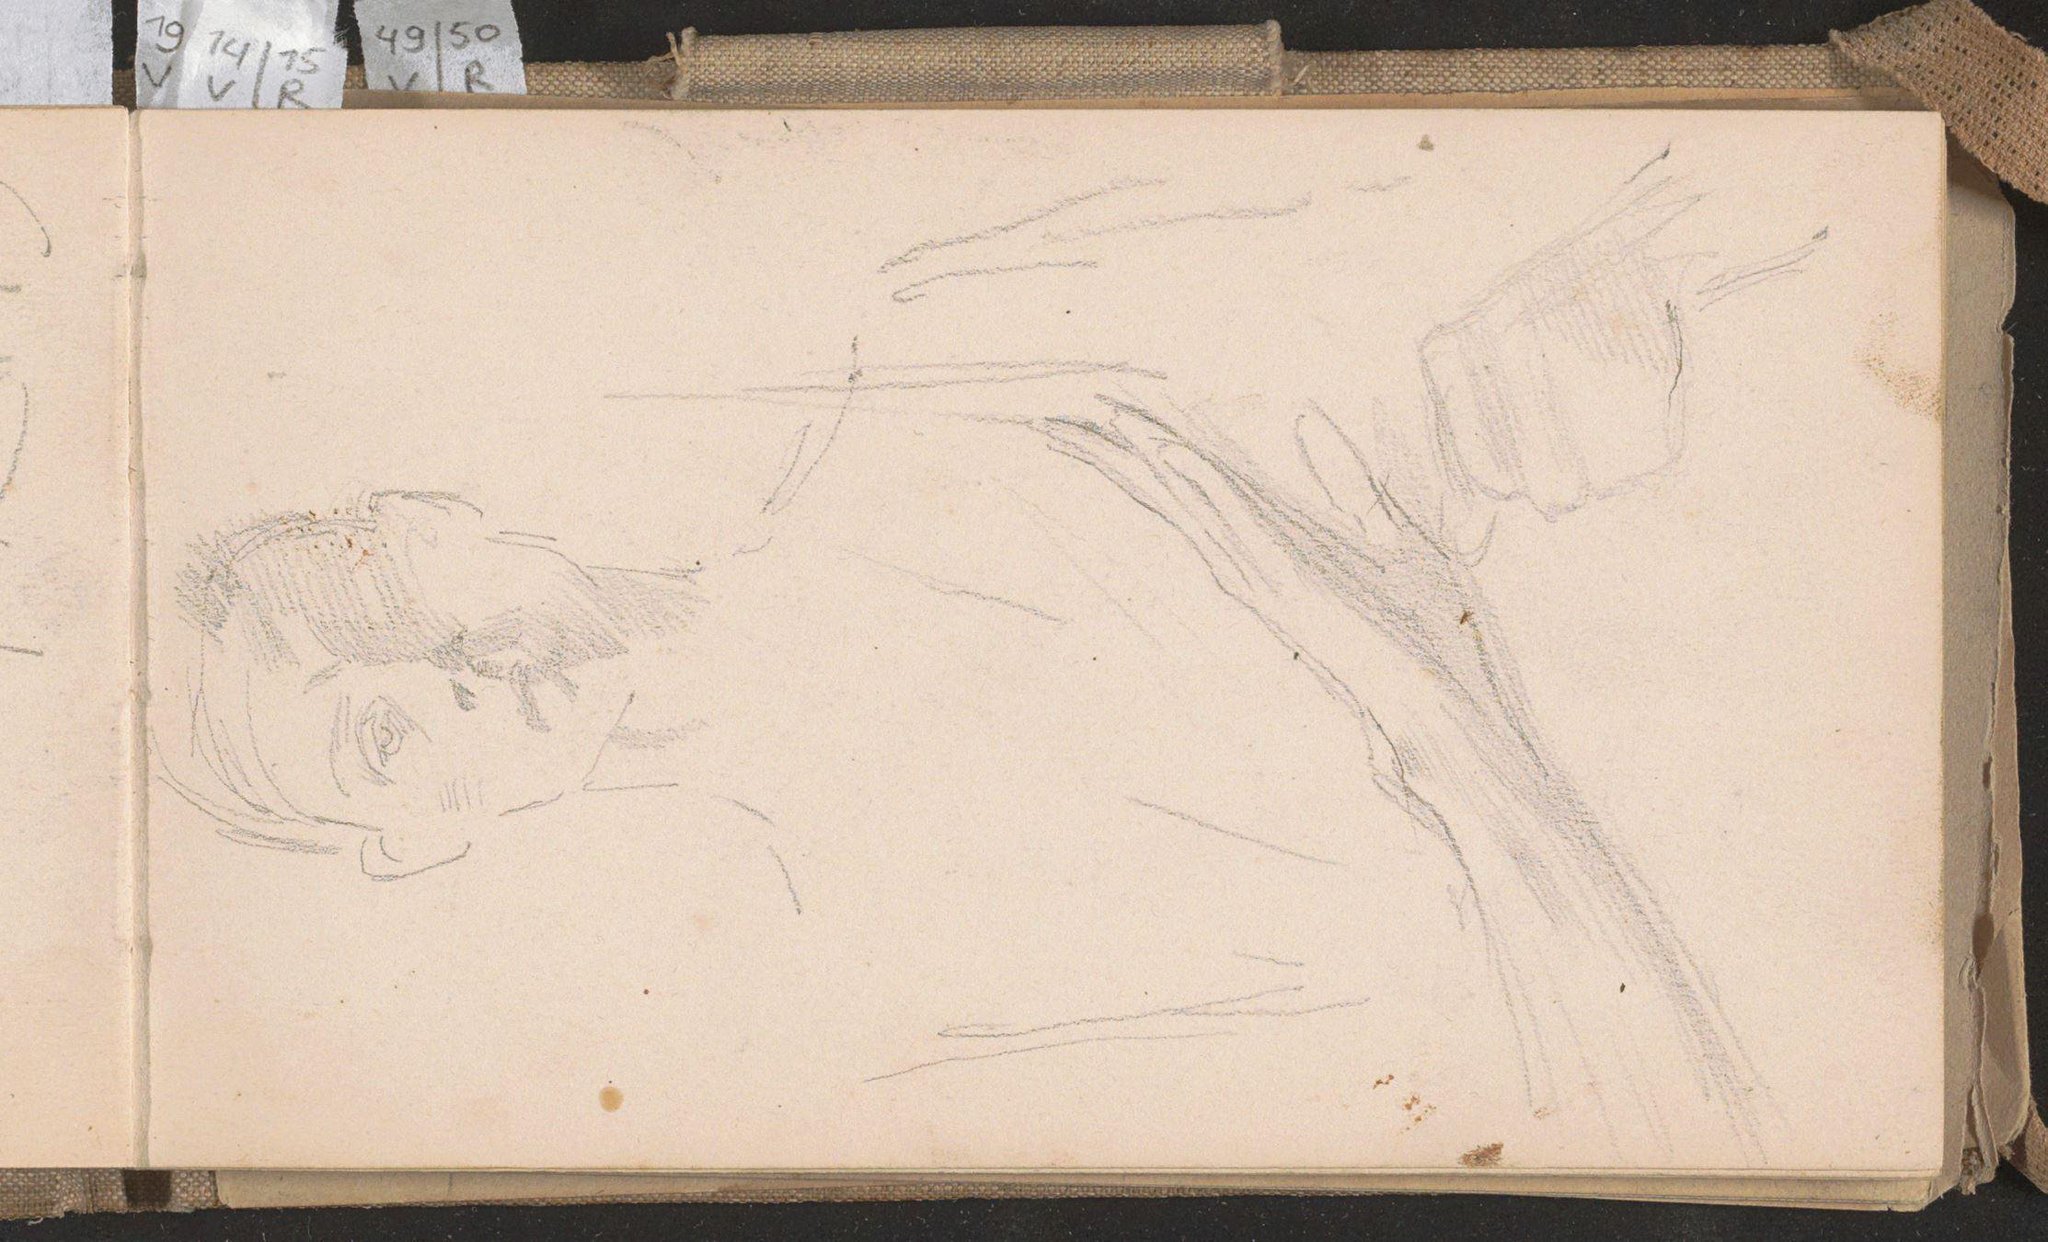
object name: sketchbook leaf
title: Staande man met een open rechterhand en gebalde linkervuist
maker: antoon derkinderen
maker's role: draughtsman, painter, print maker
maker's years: 1859-1925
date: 1892-1901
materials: paper, pencil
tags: standing figure, hand made into a fist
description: Blad 12 recto uit een schetsboek met 51 bladen.